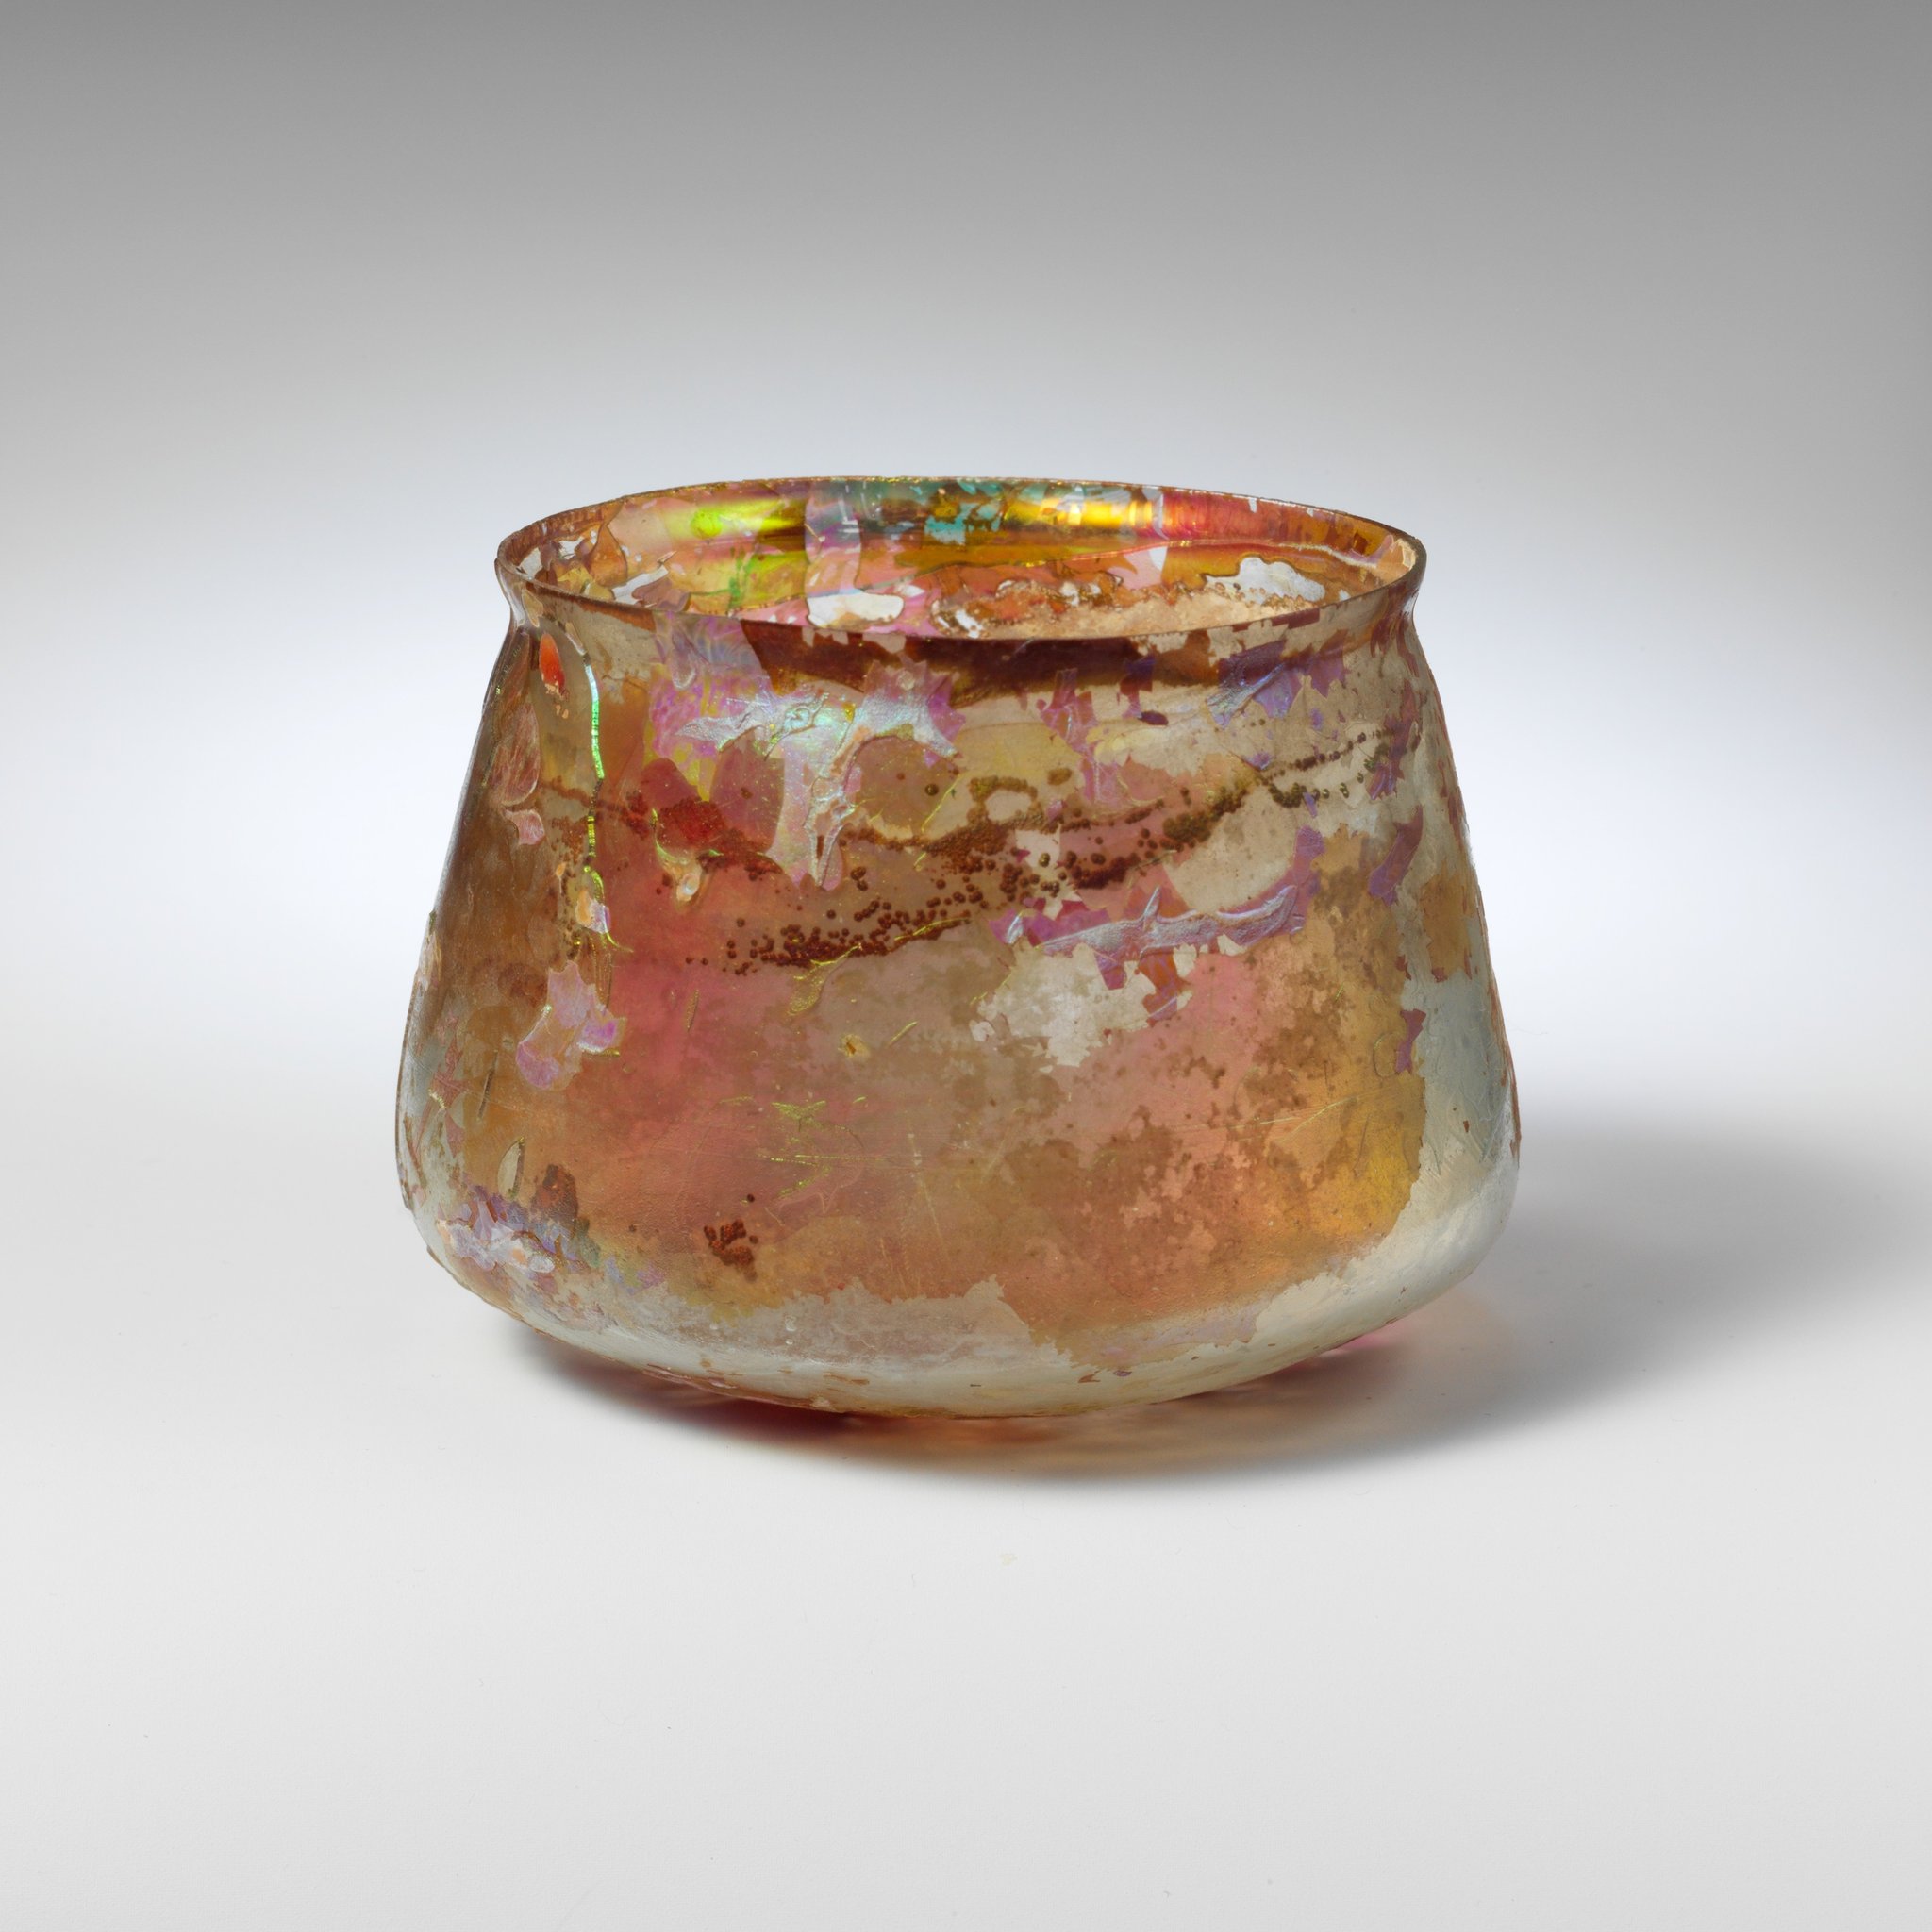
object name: bowl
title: Glass cup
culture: roman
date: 101-300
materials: glass